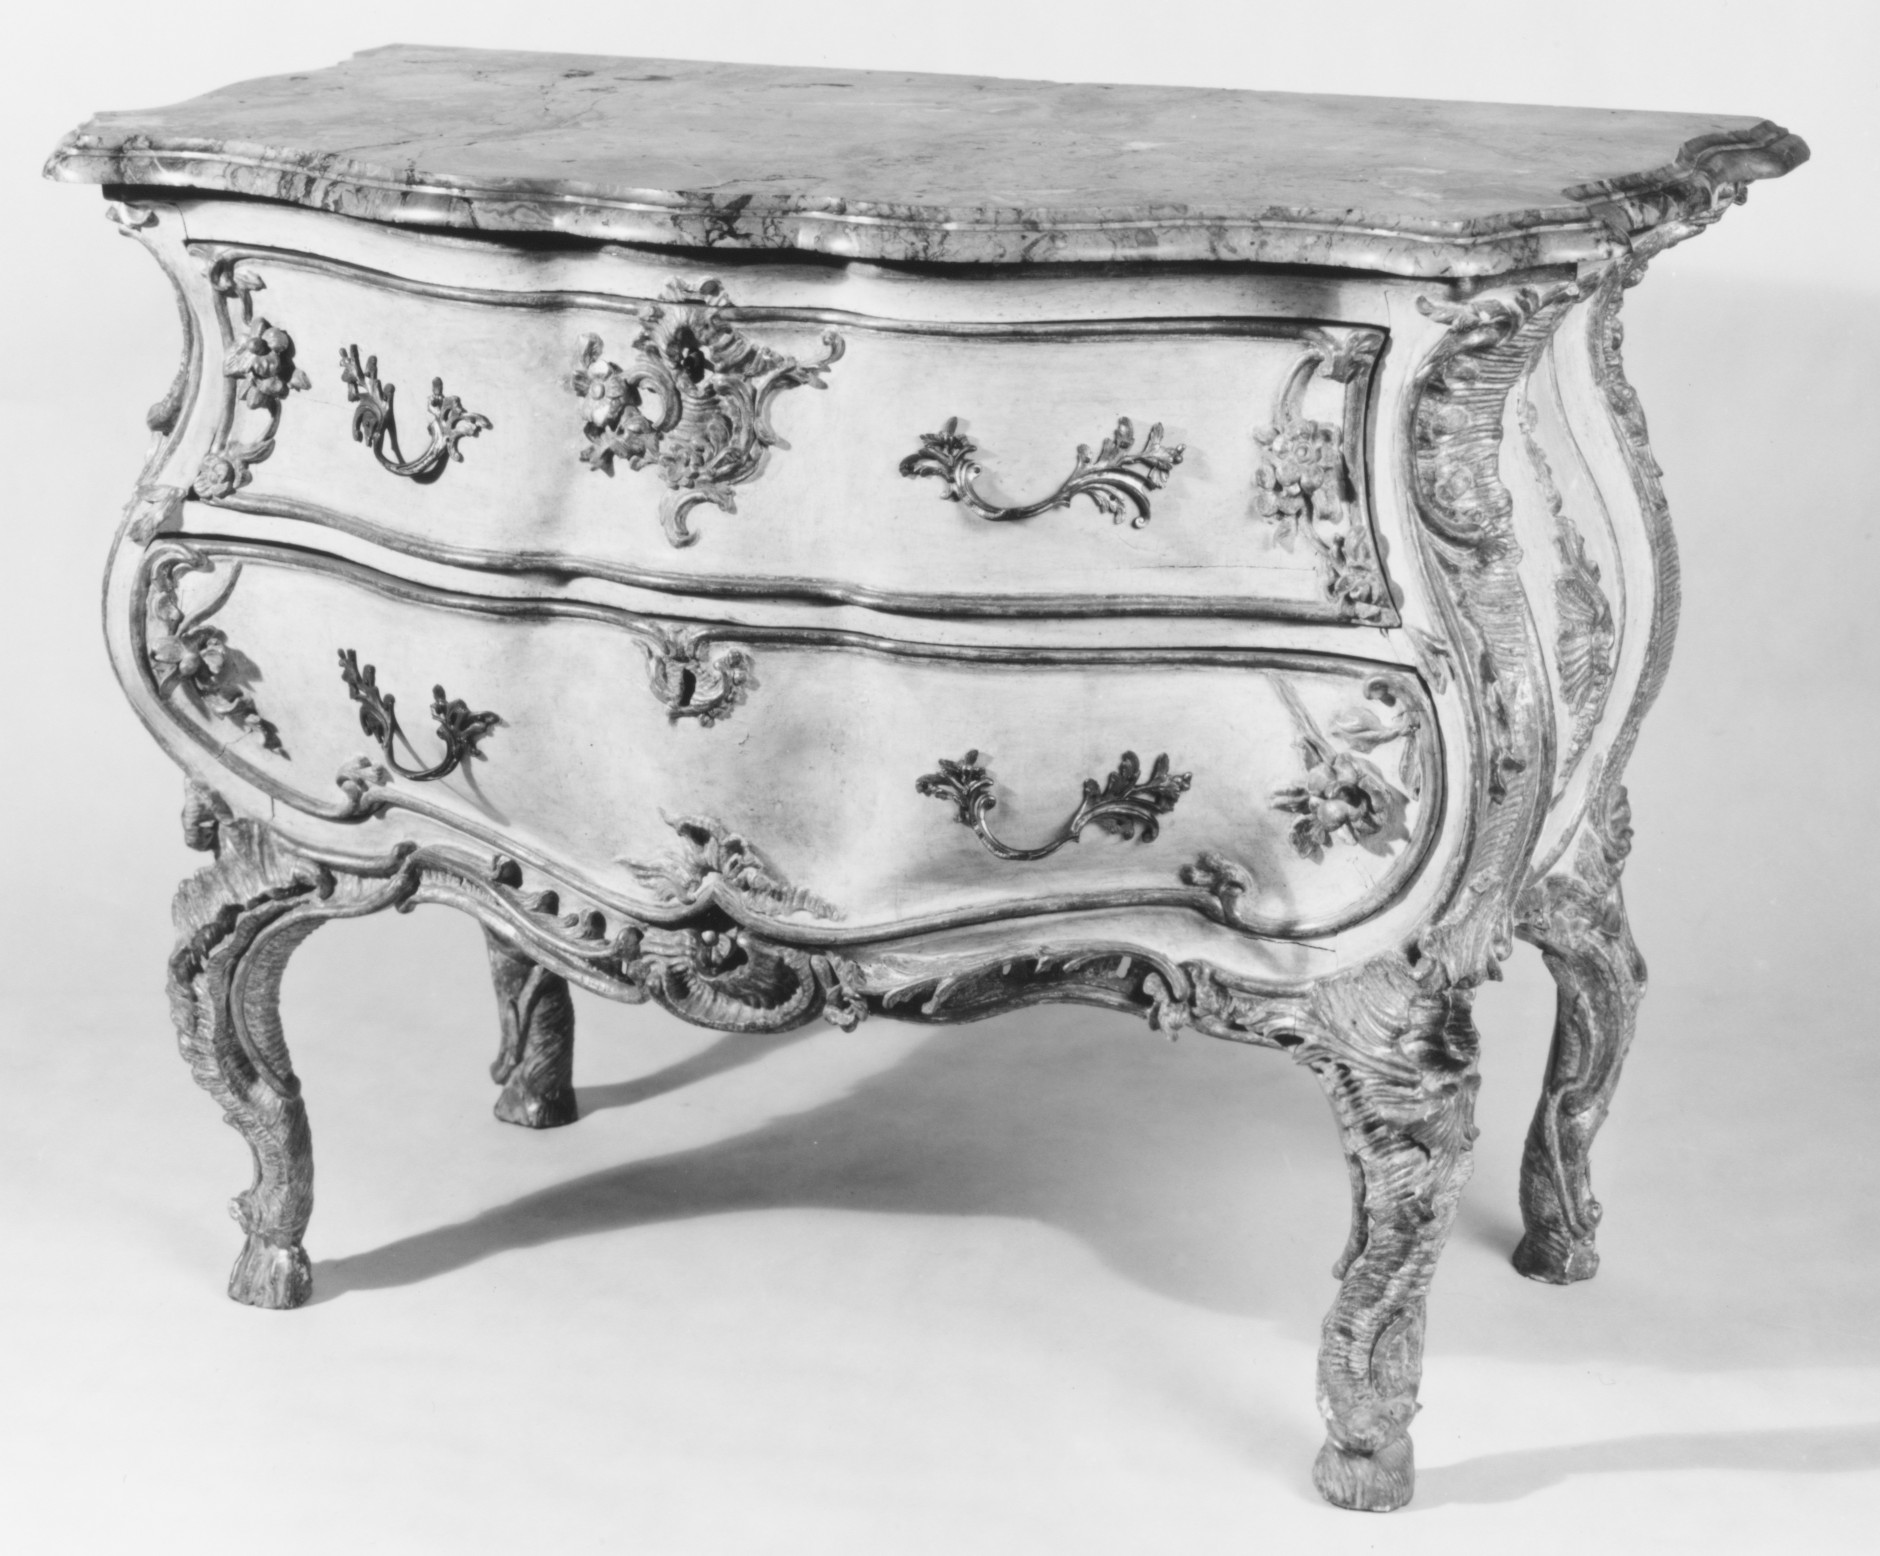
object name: commode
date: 1740-1750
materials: marble, wood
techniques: gilding, painting